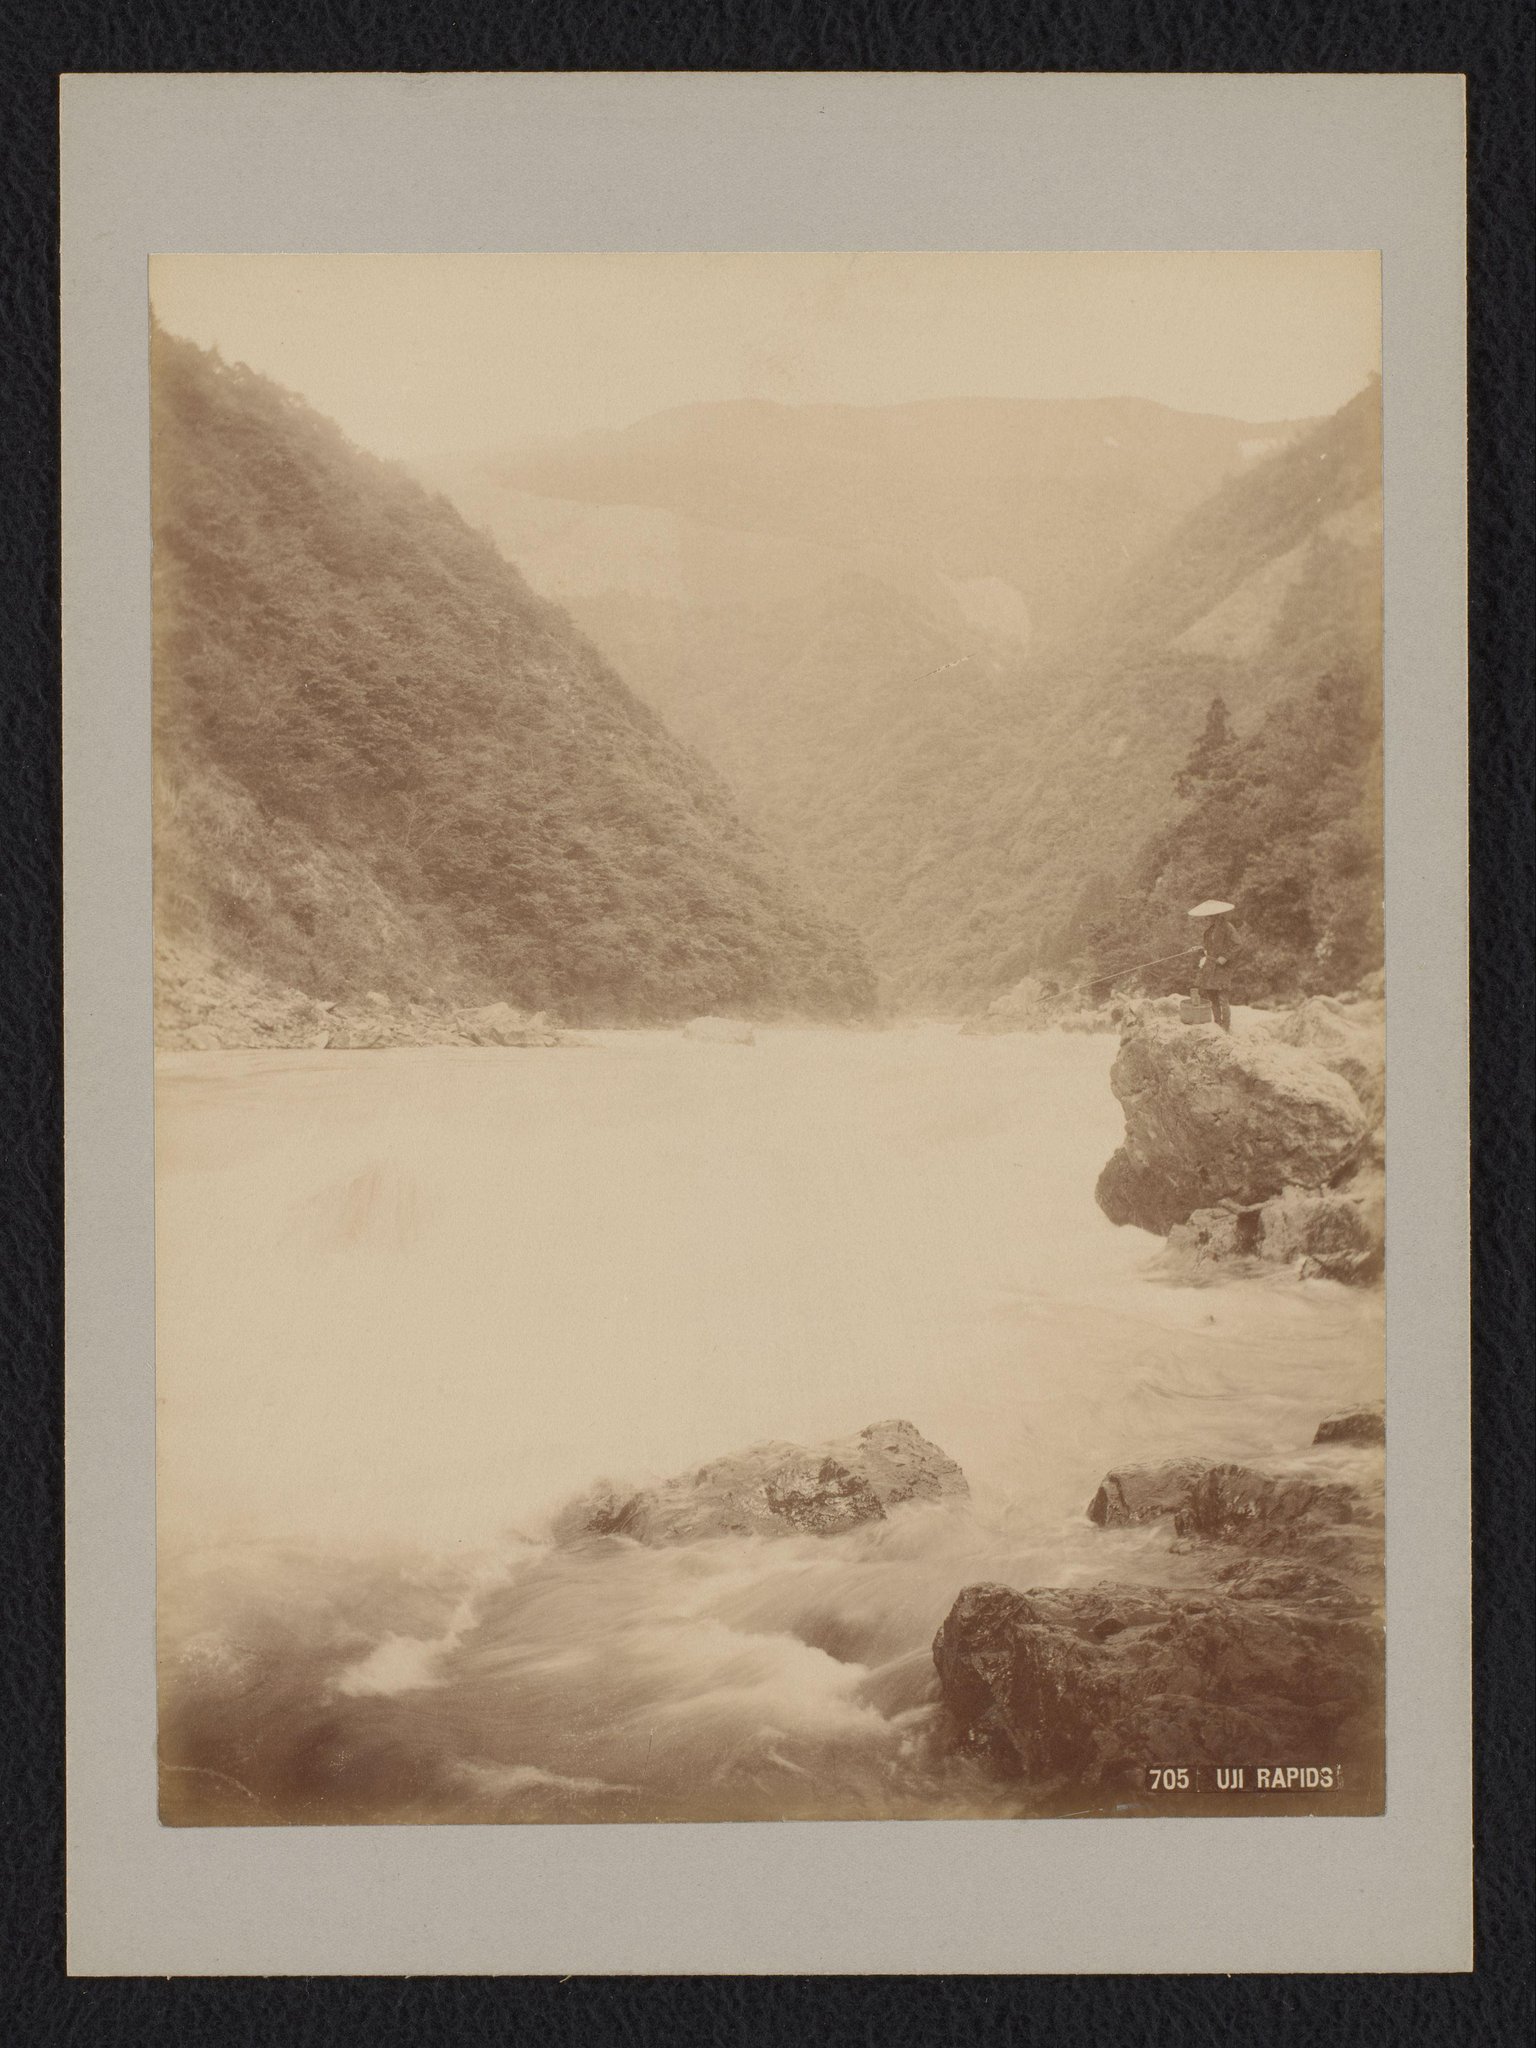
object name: photograph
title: Stroomversnellingen in Uji rivier, Uji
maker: Anonymous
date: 1895-1915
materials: cardboard, photographic support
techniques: albumen print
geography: uji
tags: uji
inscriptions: number: ‘11.’